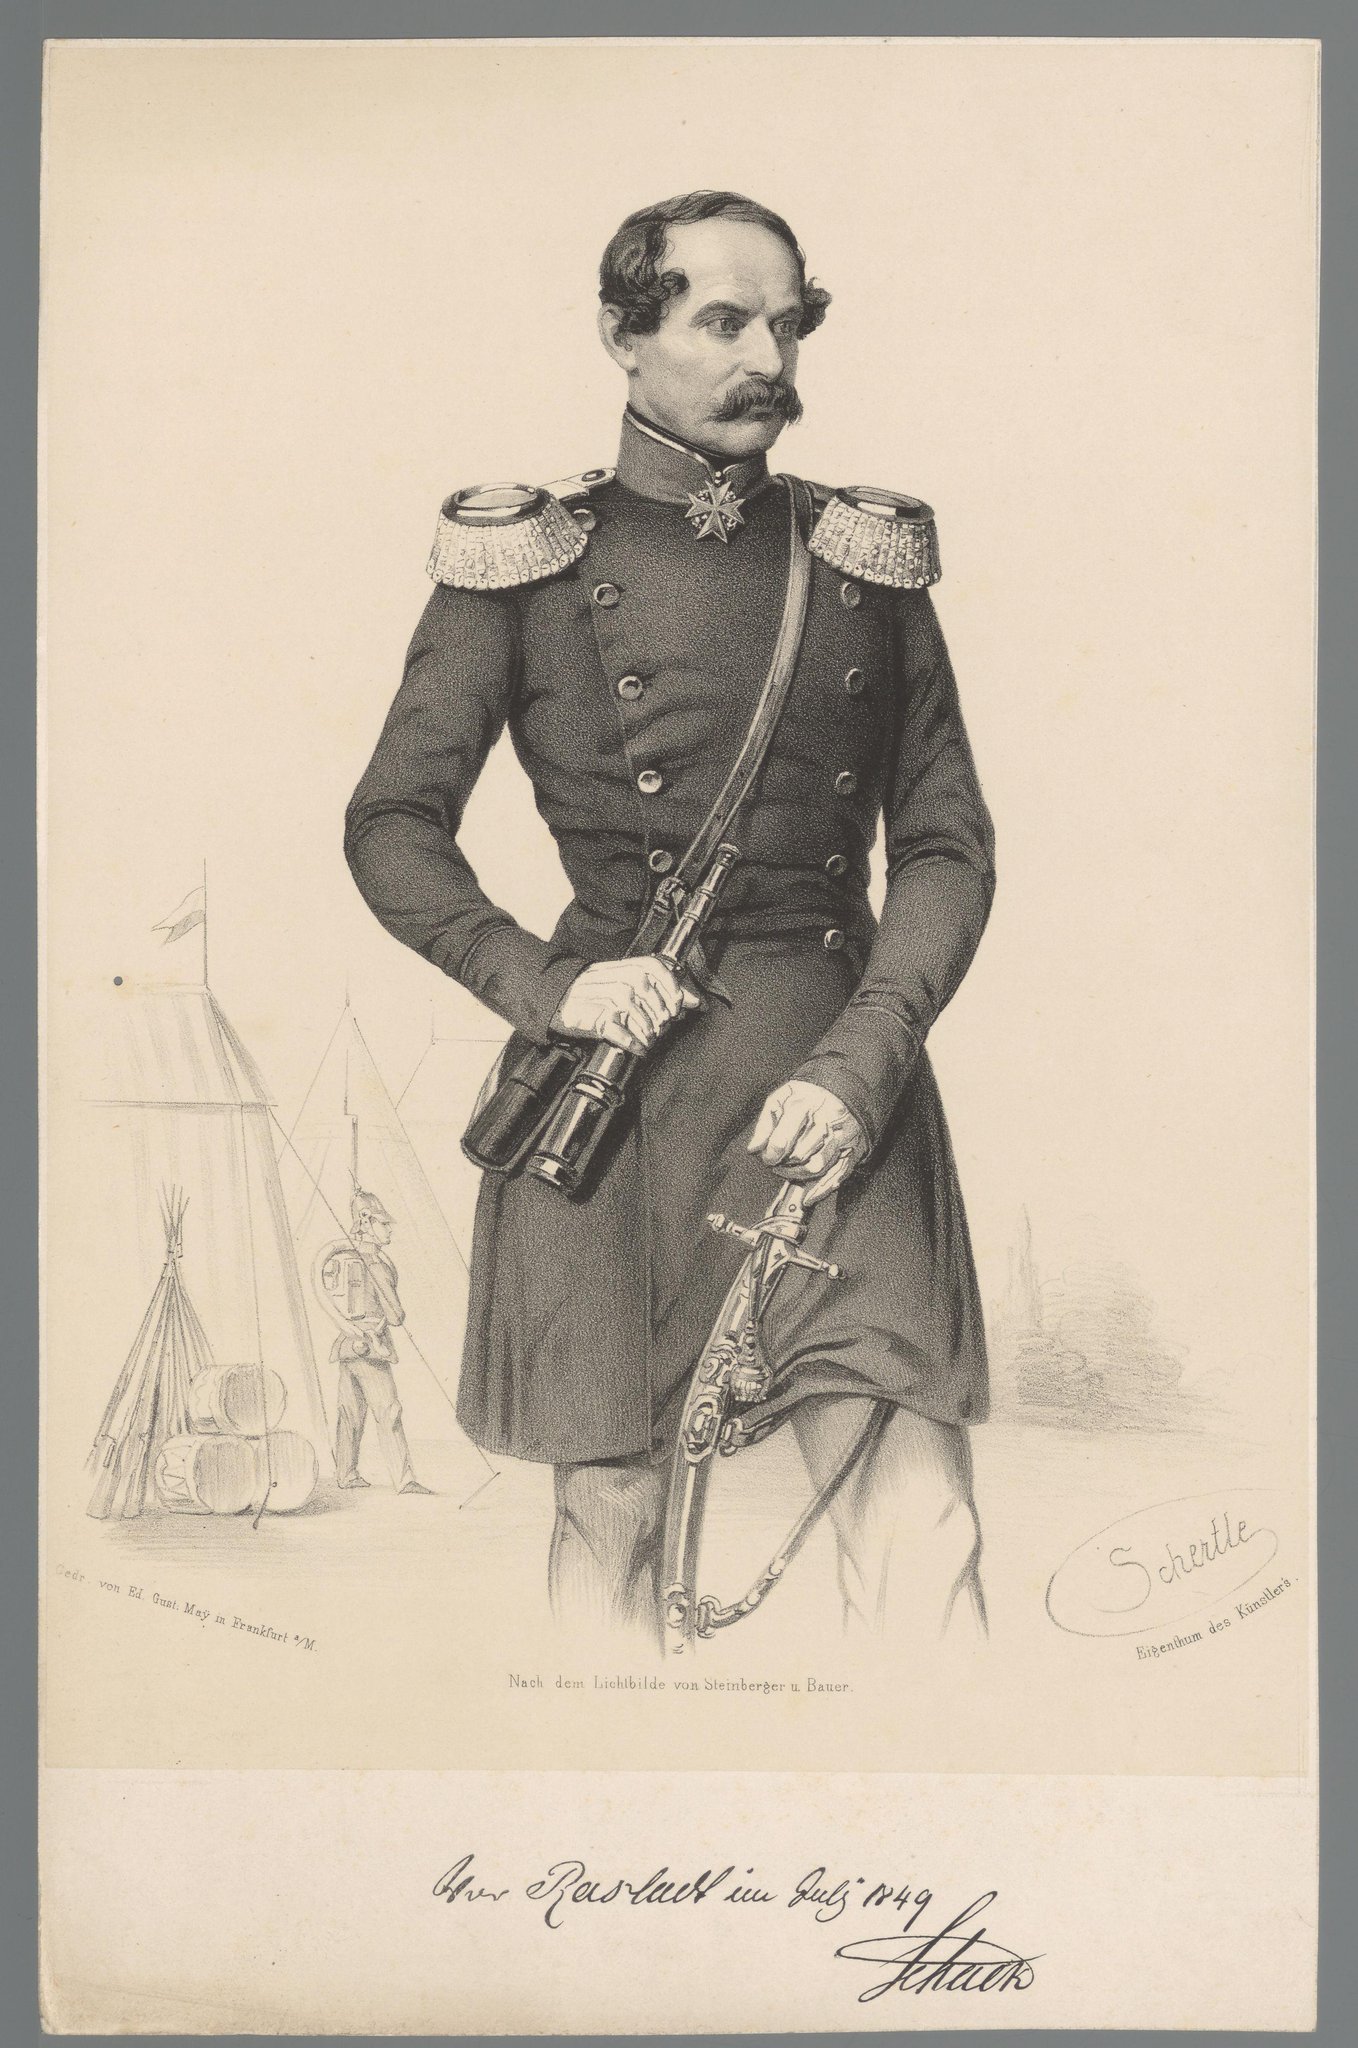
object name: print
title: Portret van een onbekende man, mogelijk Adolph Friedrich von Schack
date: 1849-1885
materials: paper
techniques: lithograph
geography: frankfurt am main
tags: adult man, historical persons, (military) uniforms, beard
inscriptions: collector's mark: Lugt 2228